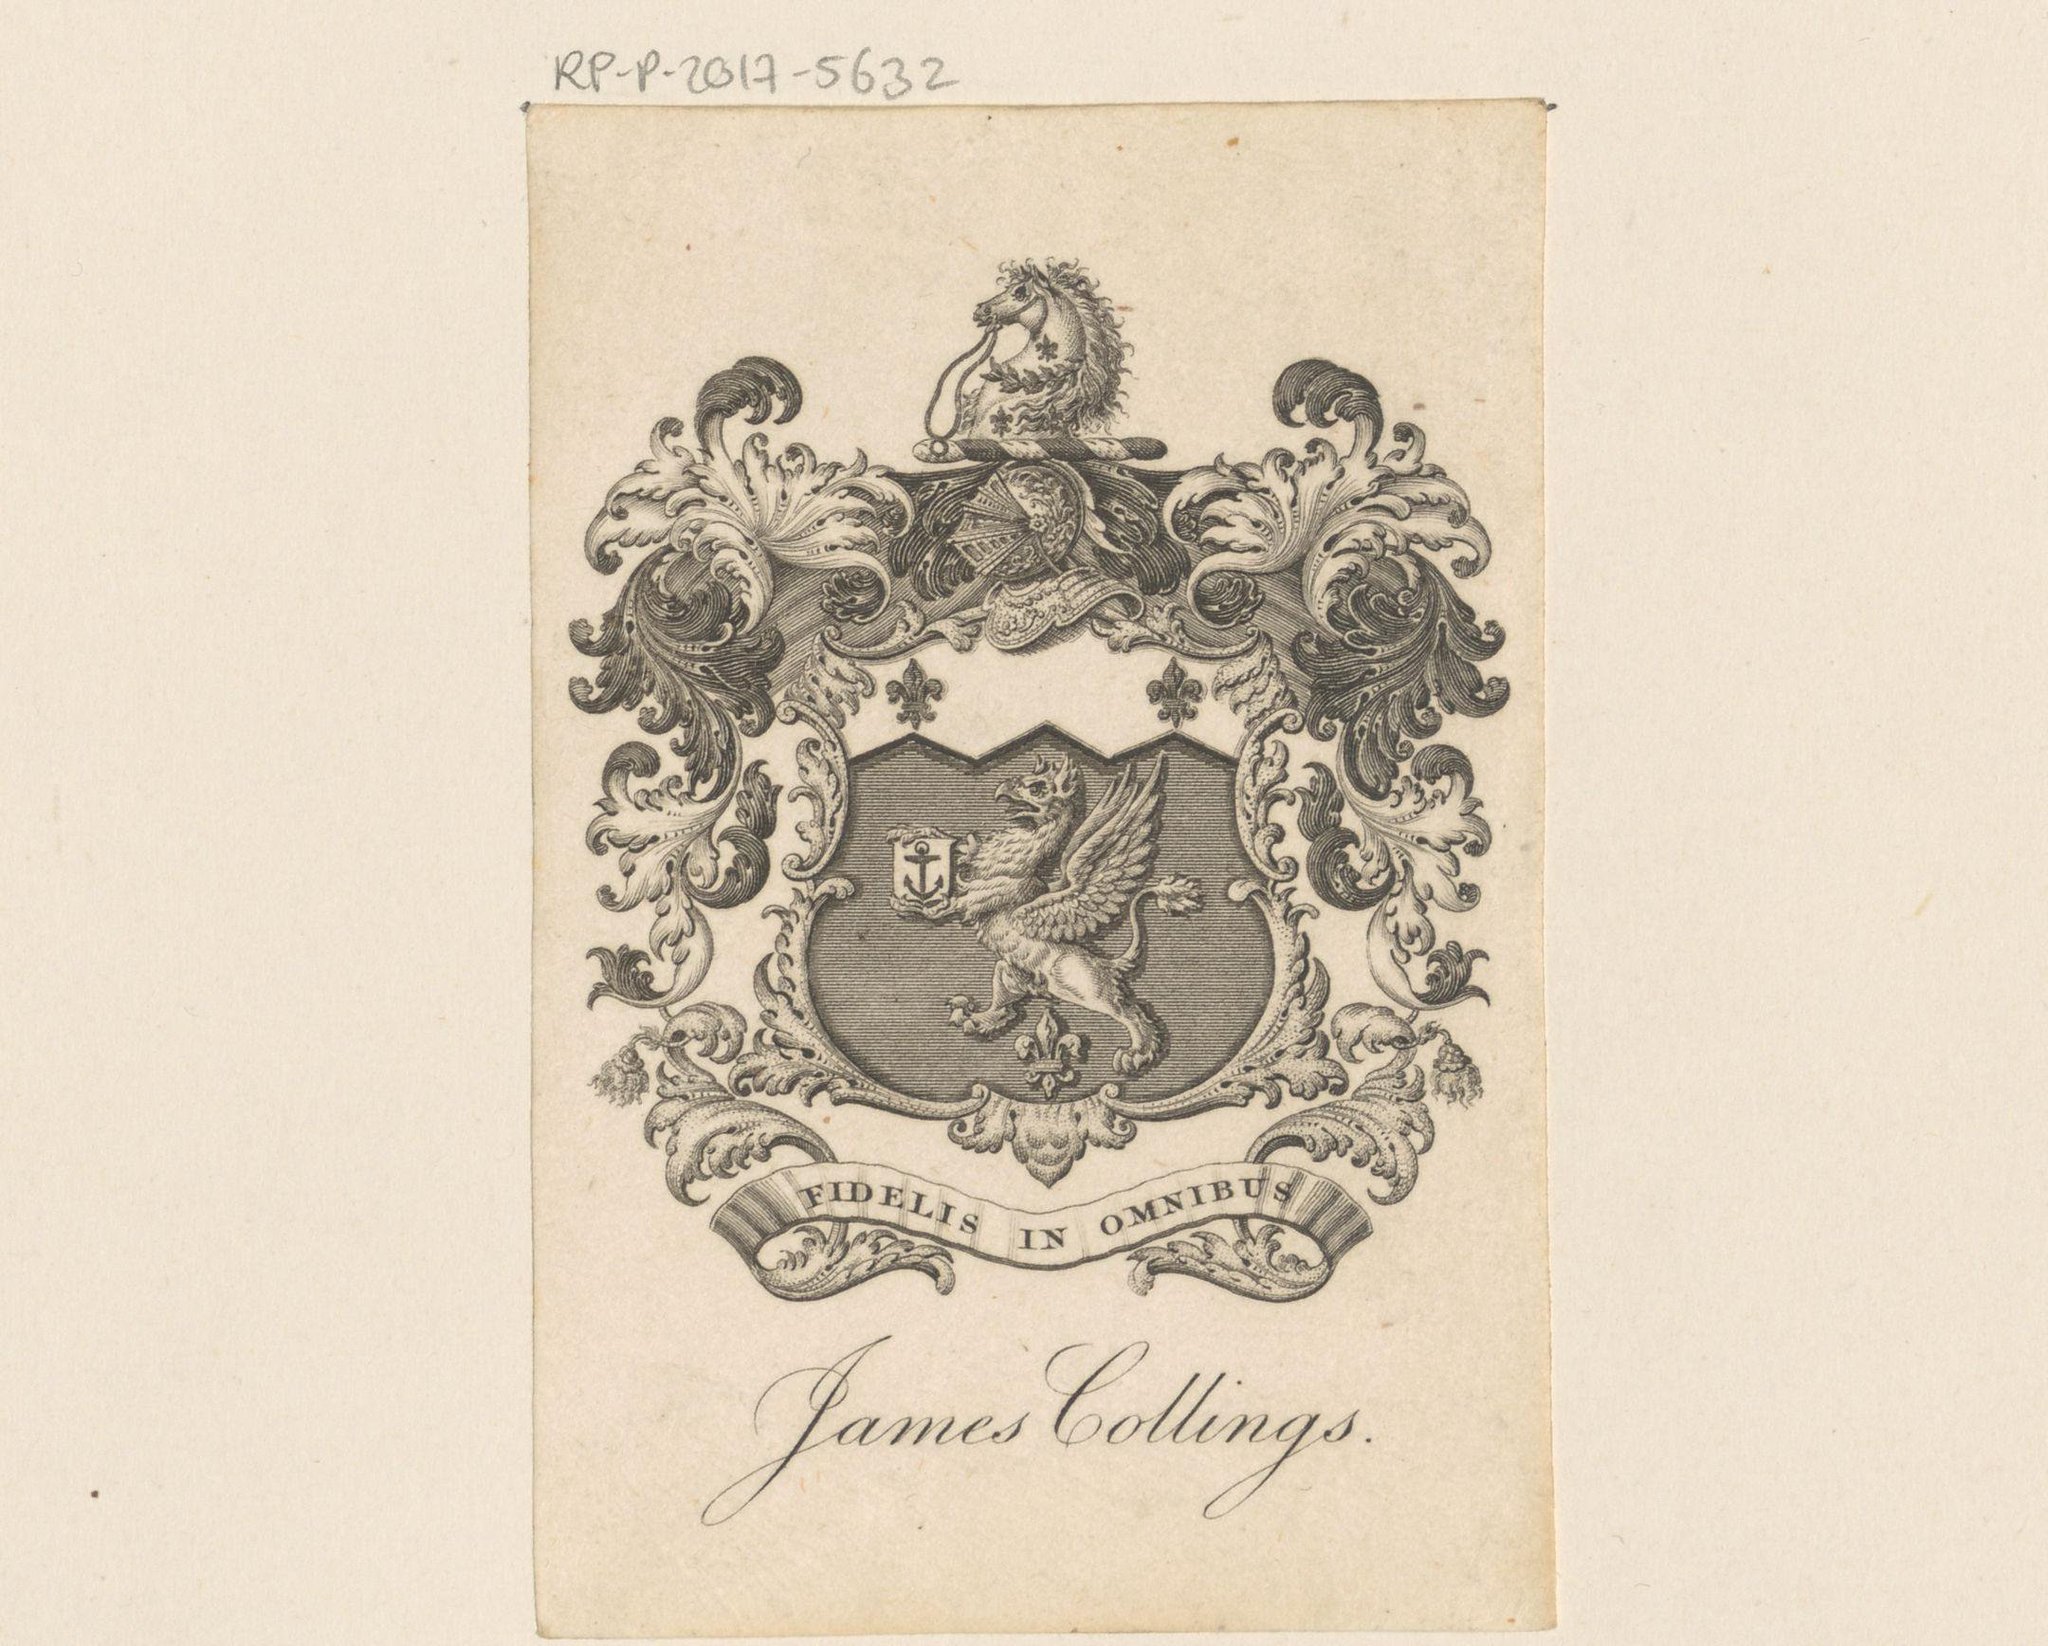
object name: bookplate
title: Ex libris van James Collings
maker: Anonymous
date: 1750-1849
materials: paper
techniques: etching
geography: england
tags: james collins, griffin (lion/eagle); 'griffo' (ripa), armorial bearing, heraldry